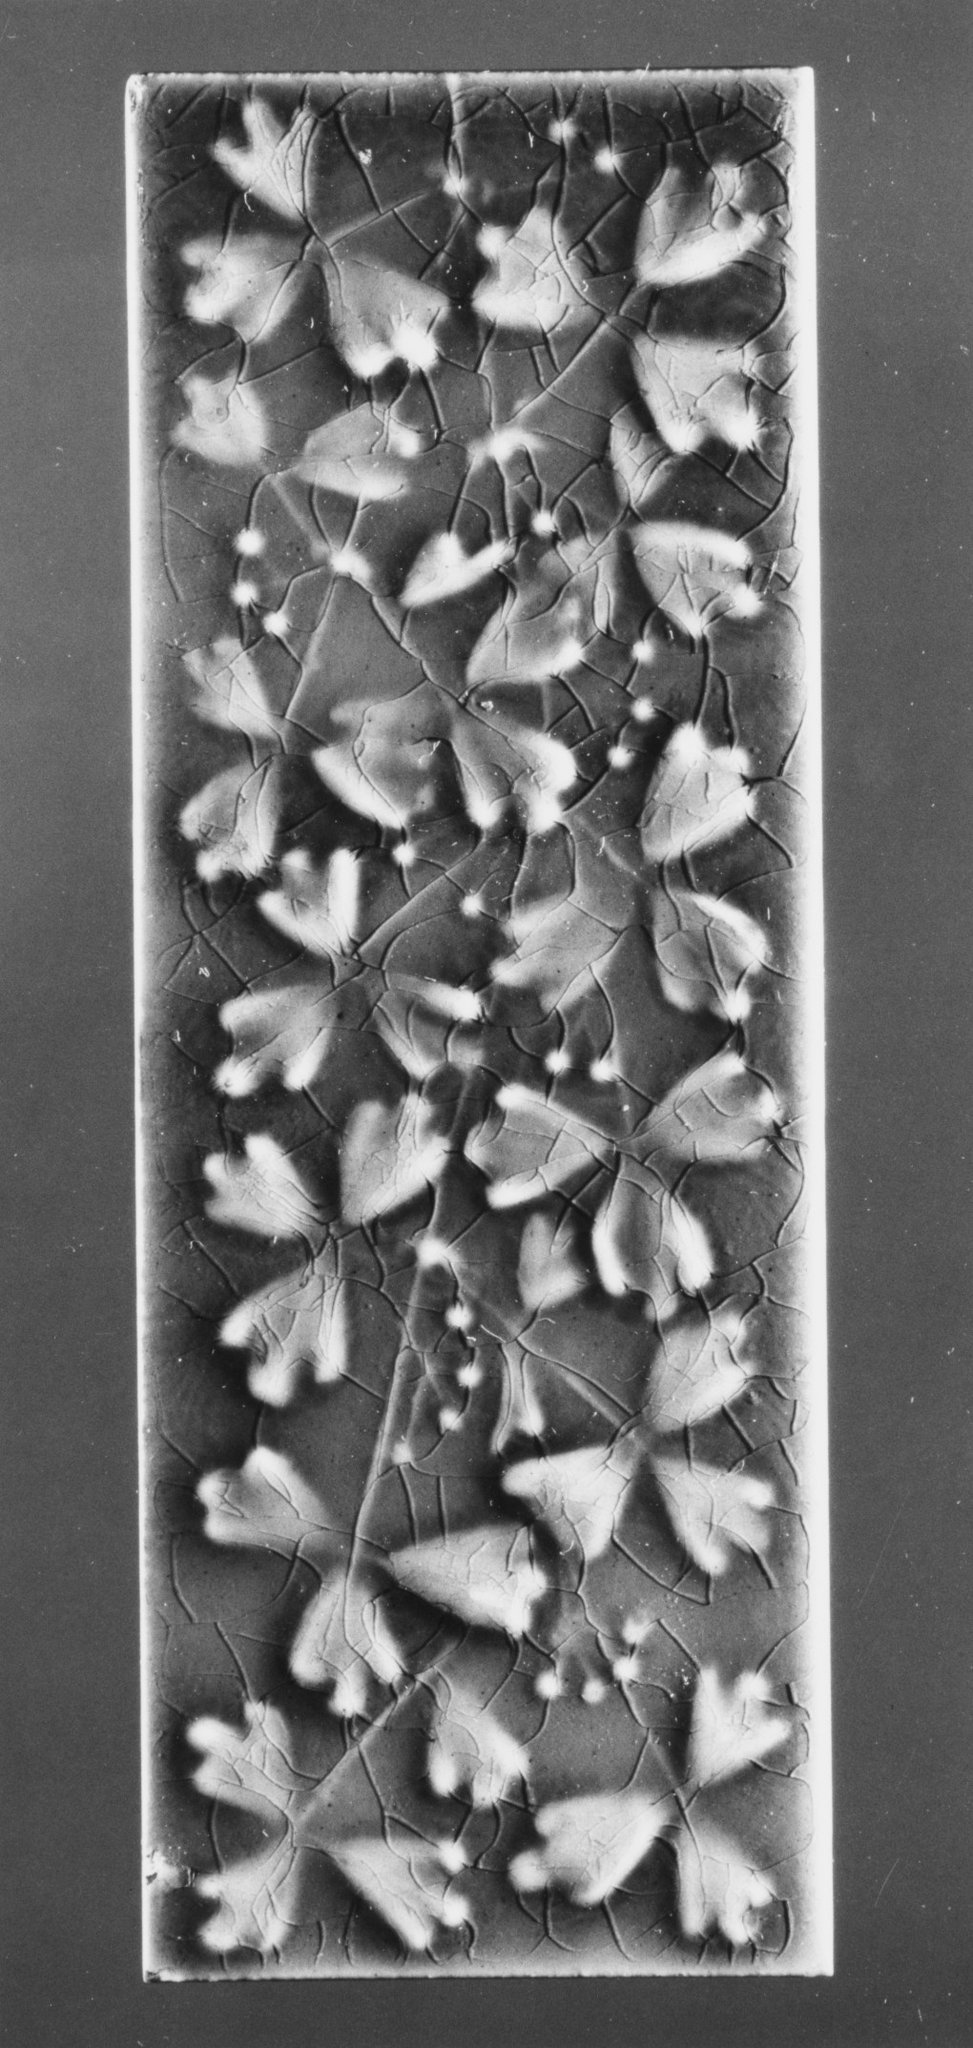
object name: tile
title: Border Tile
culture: american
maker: j. and j. g. low art tile works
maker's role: maker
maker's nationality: american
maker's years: 1877-1903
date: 1885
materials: earthenware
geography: united states